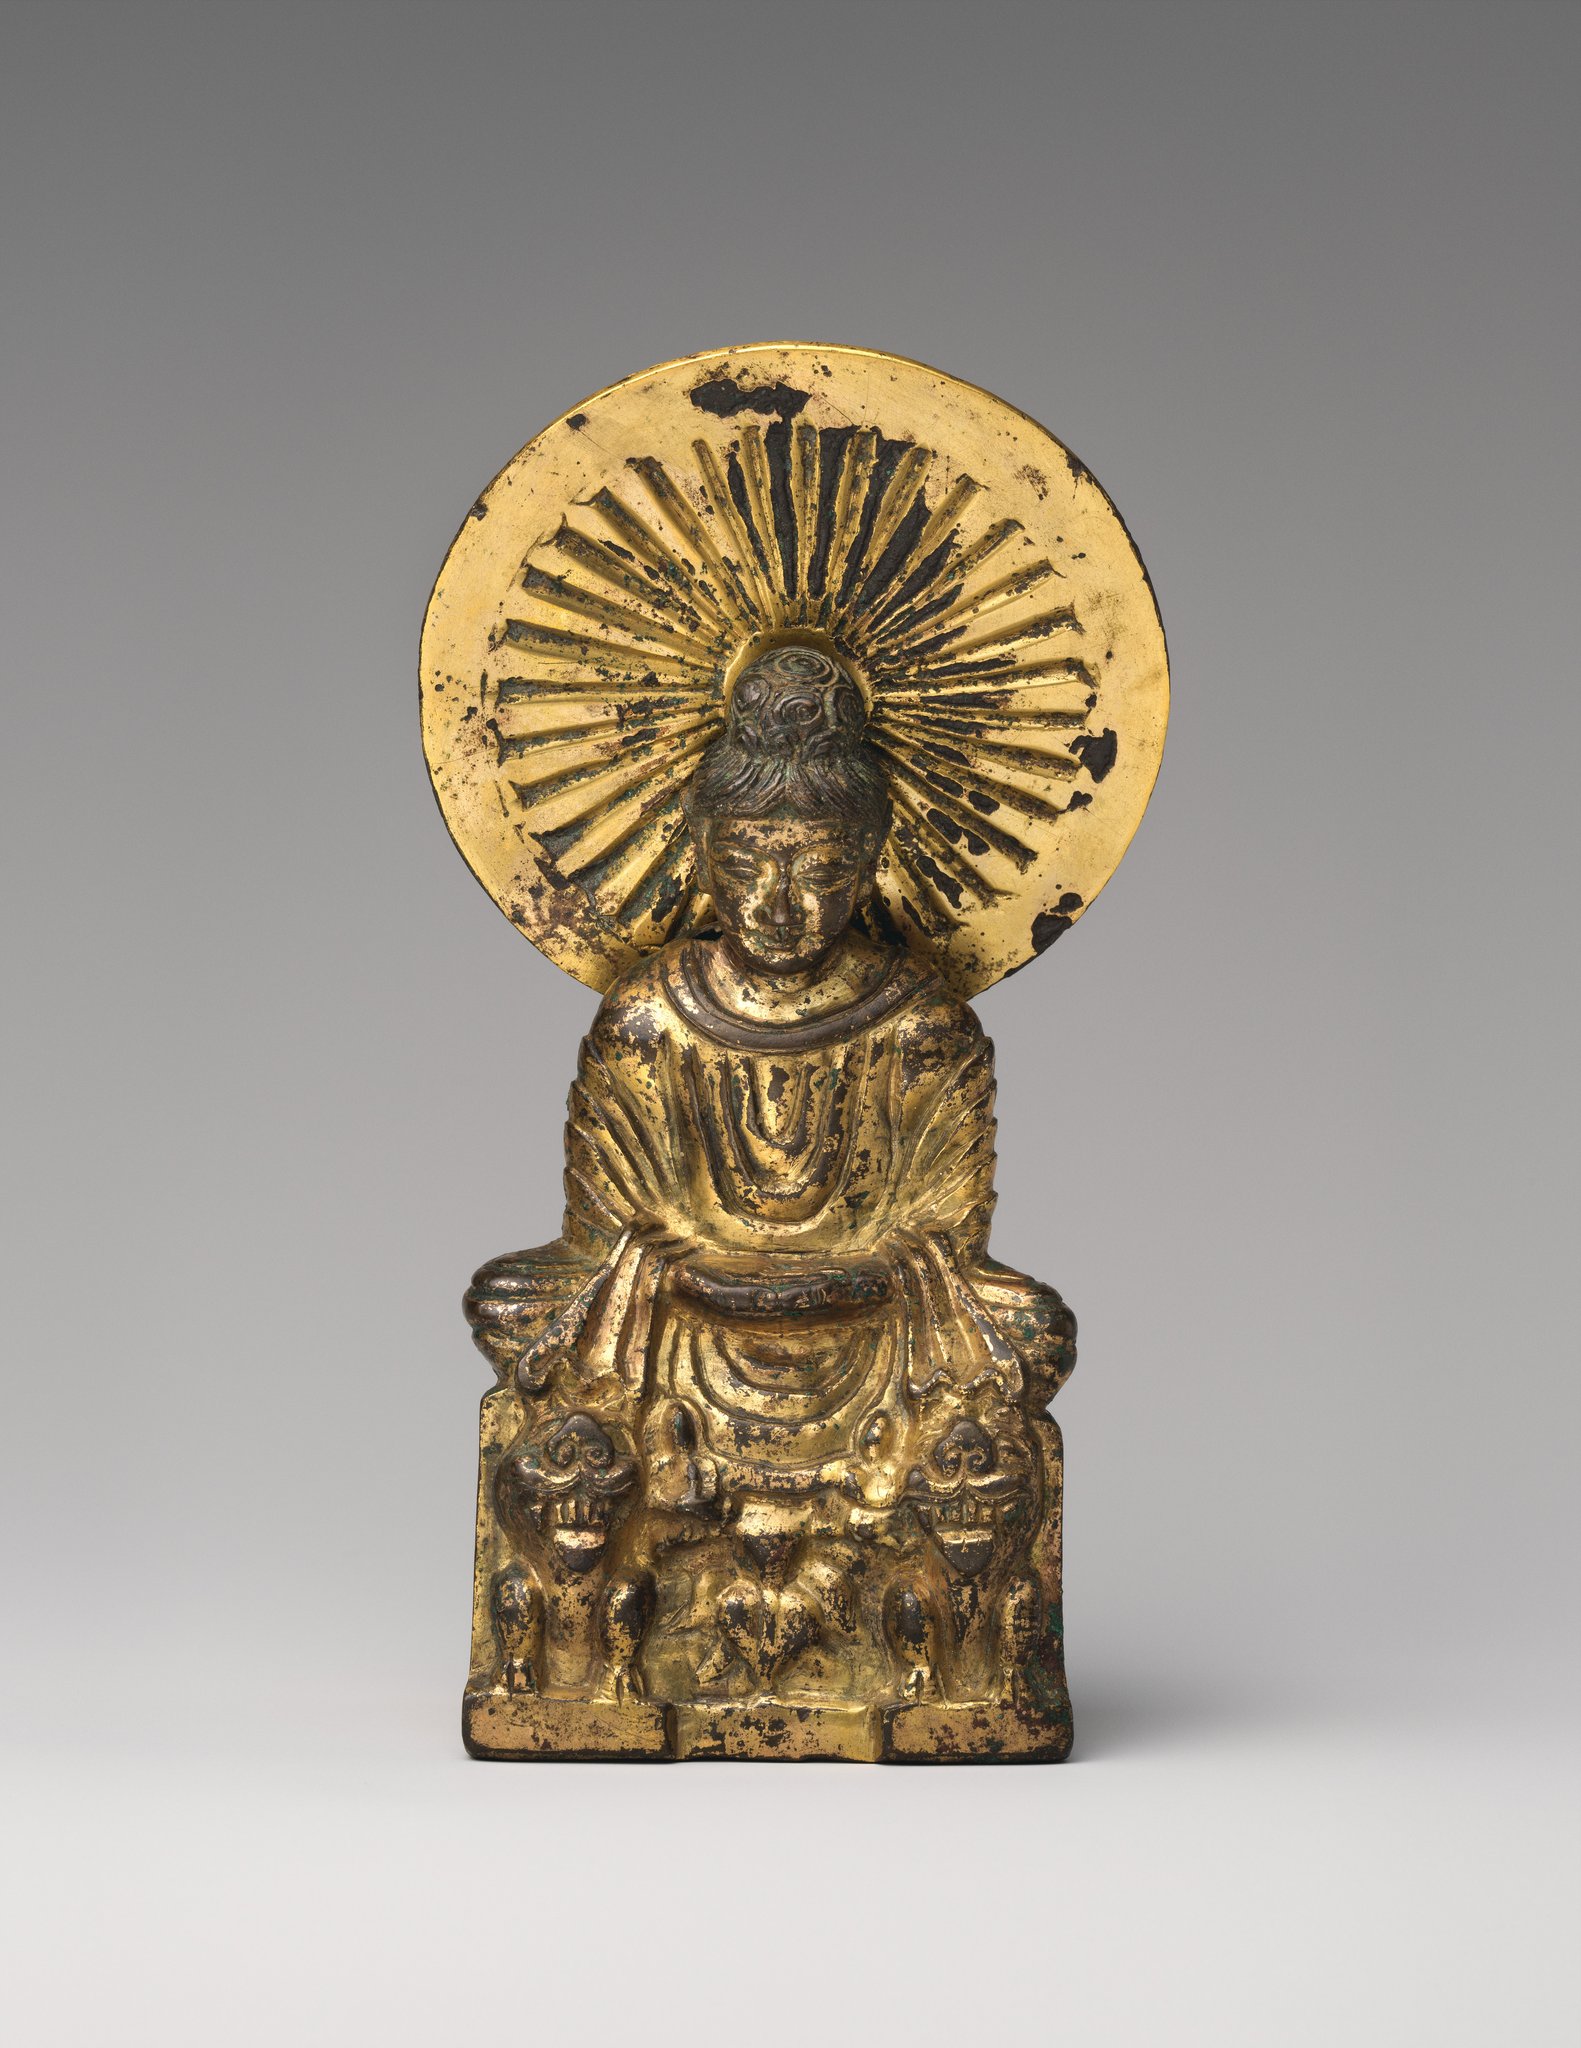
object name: figure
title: Seated Buddha, probably Shakyamuni (Shijiamouni)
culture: chinese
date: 367-433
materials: gilt bronze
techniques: casting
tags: buddhism,buddha